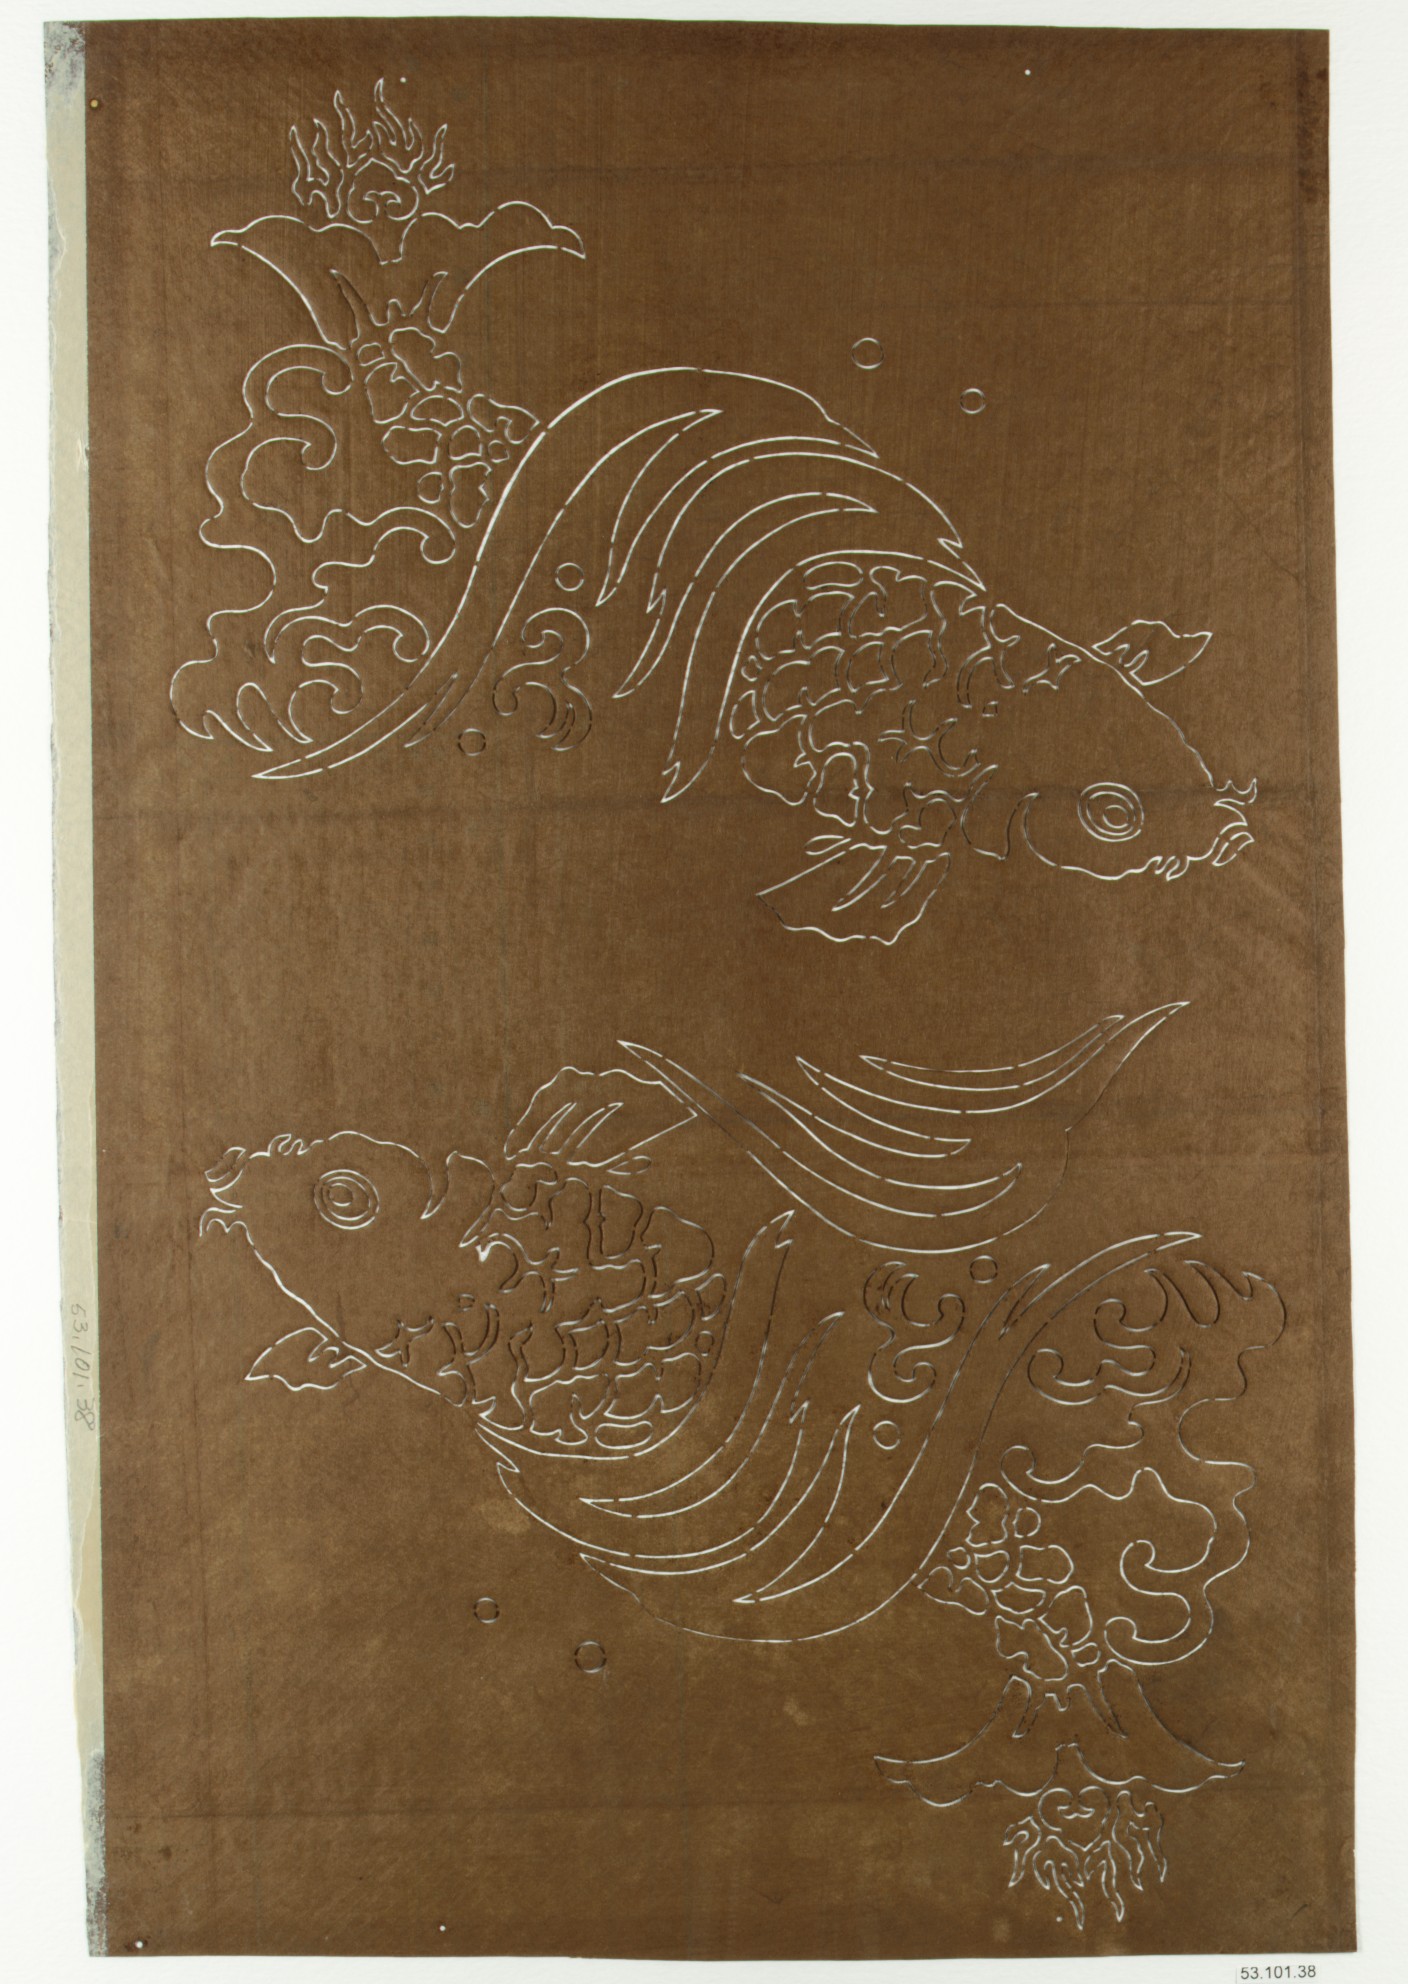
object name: stencil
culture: japanese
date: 1615-1868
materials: paper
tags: fish